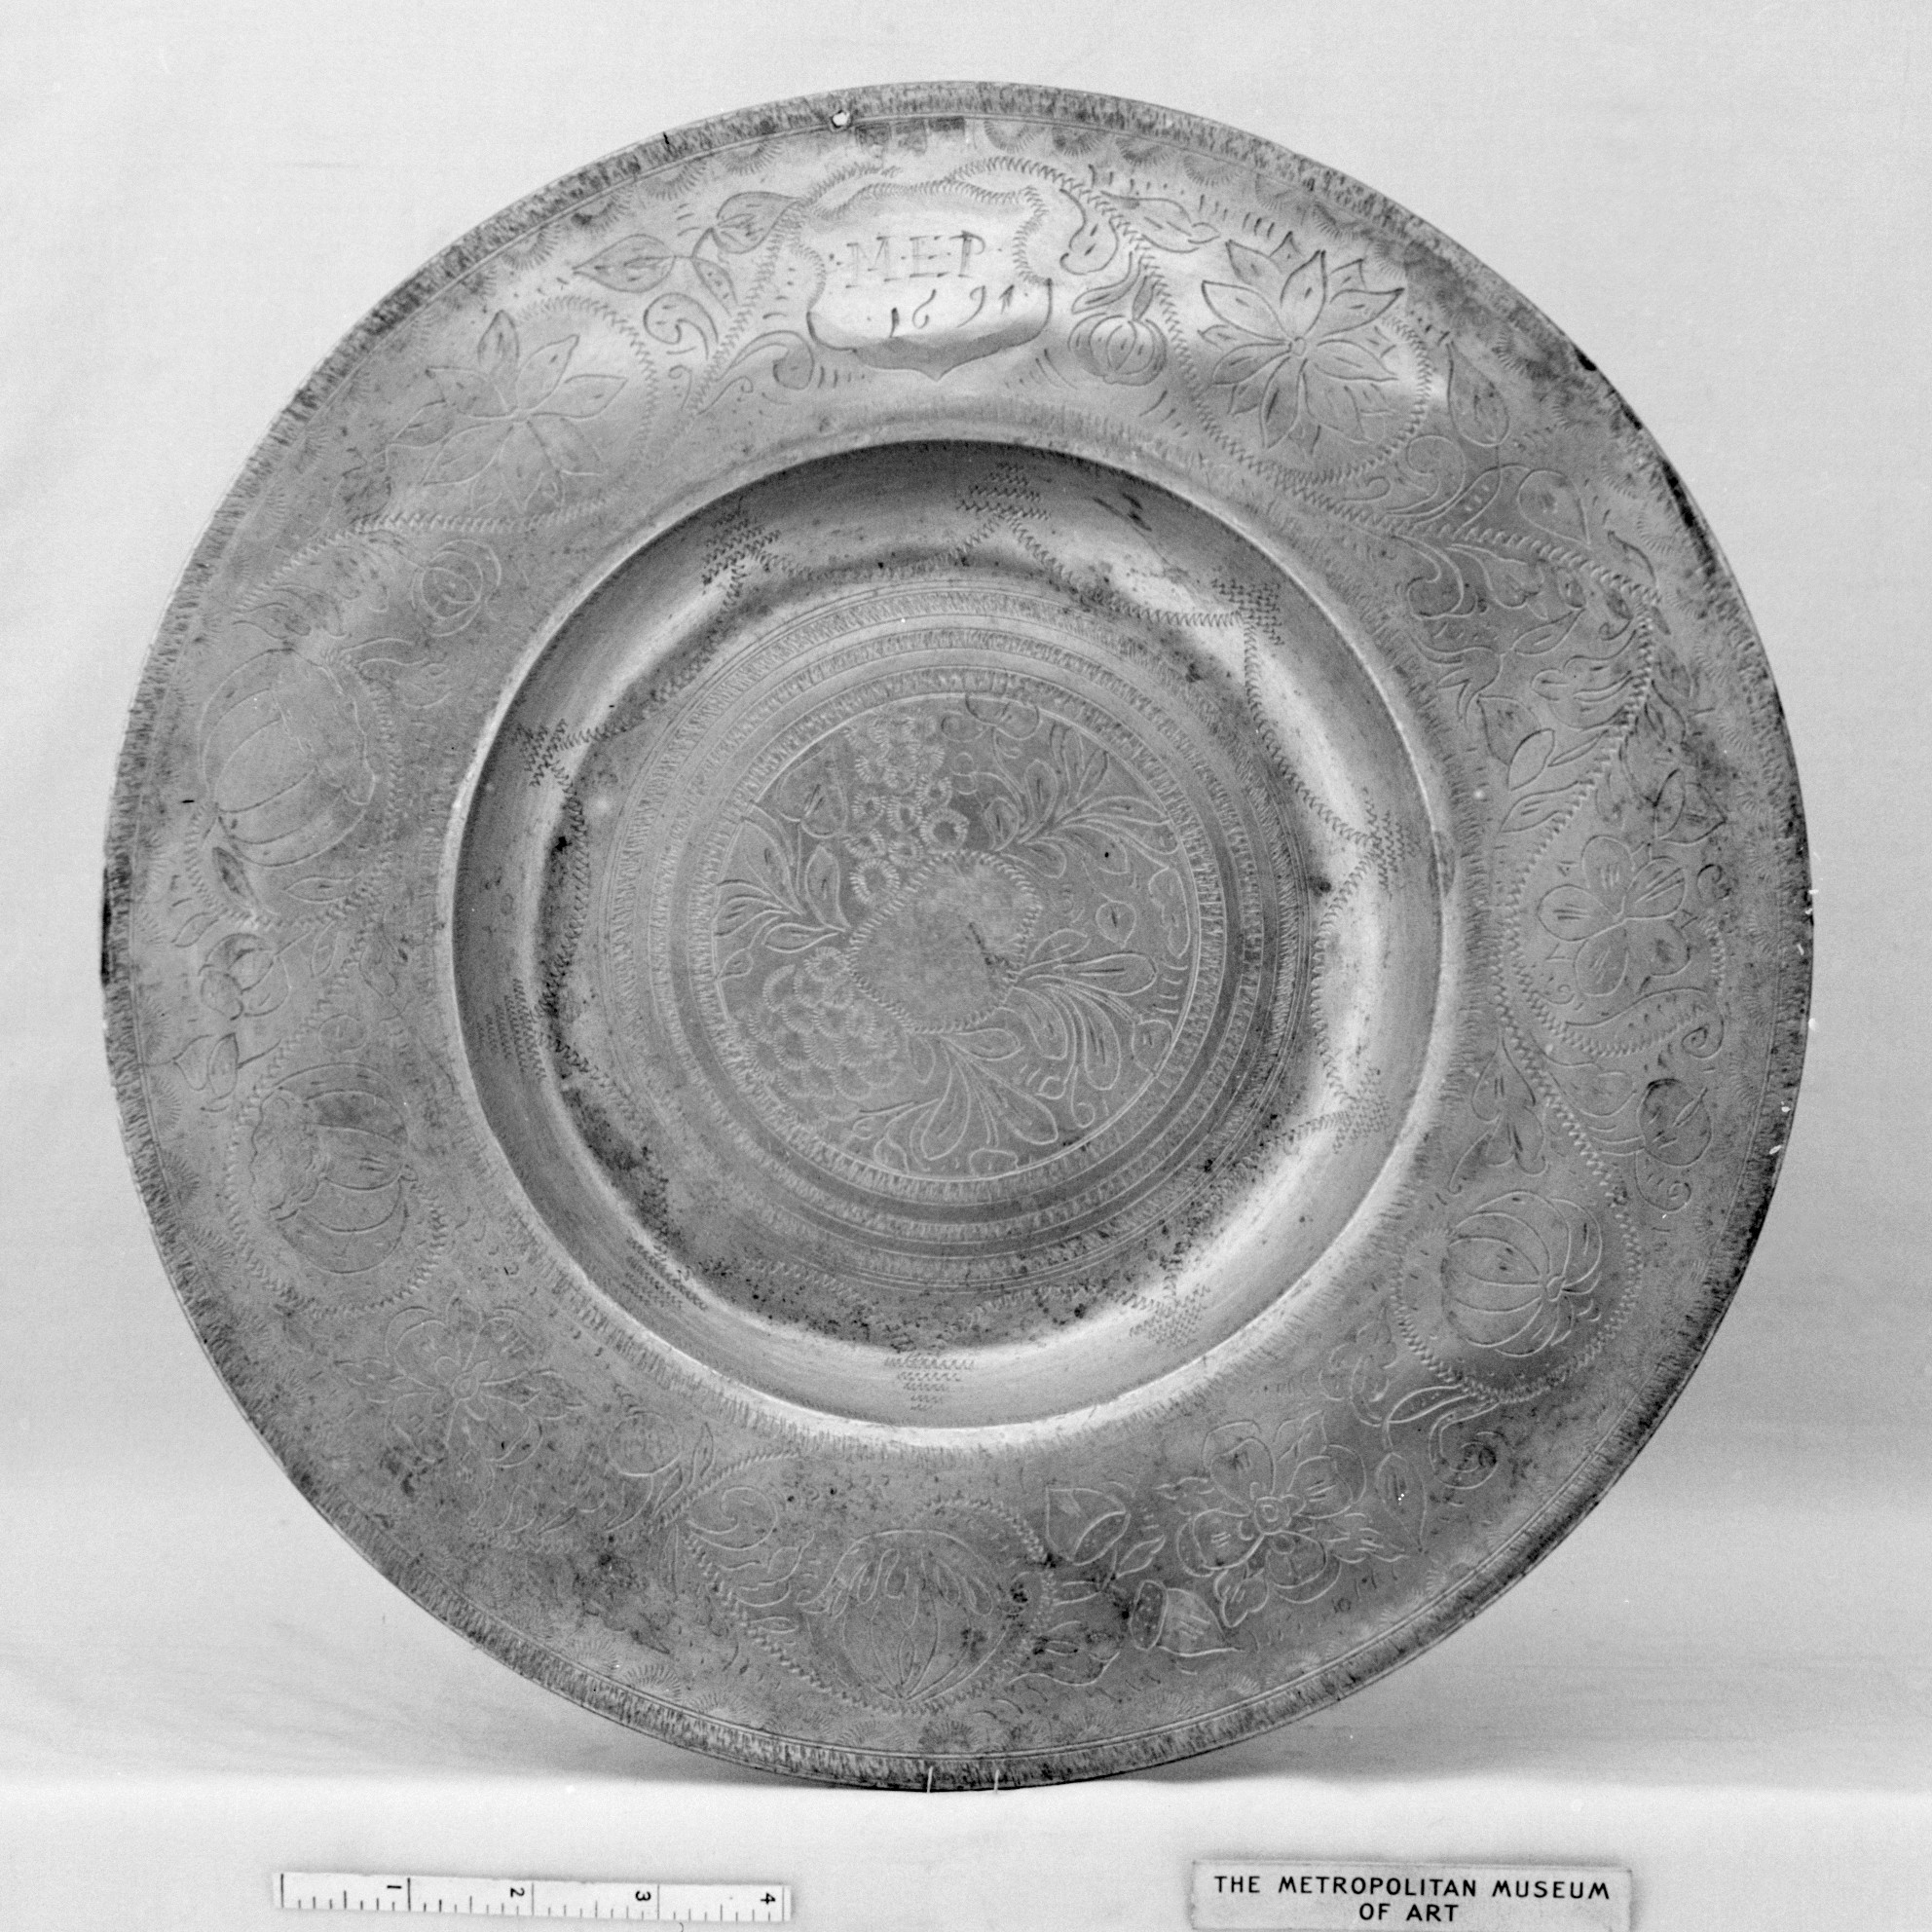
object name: platter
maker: jacob schramm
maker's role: maker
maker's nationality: german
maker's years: 1685-1701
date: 1701-1800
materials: pewter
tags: flowers